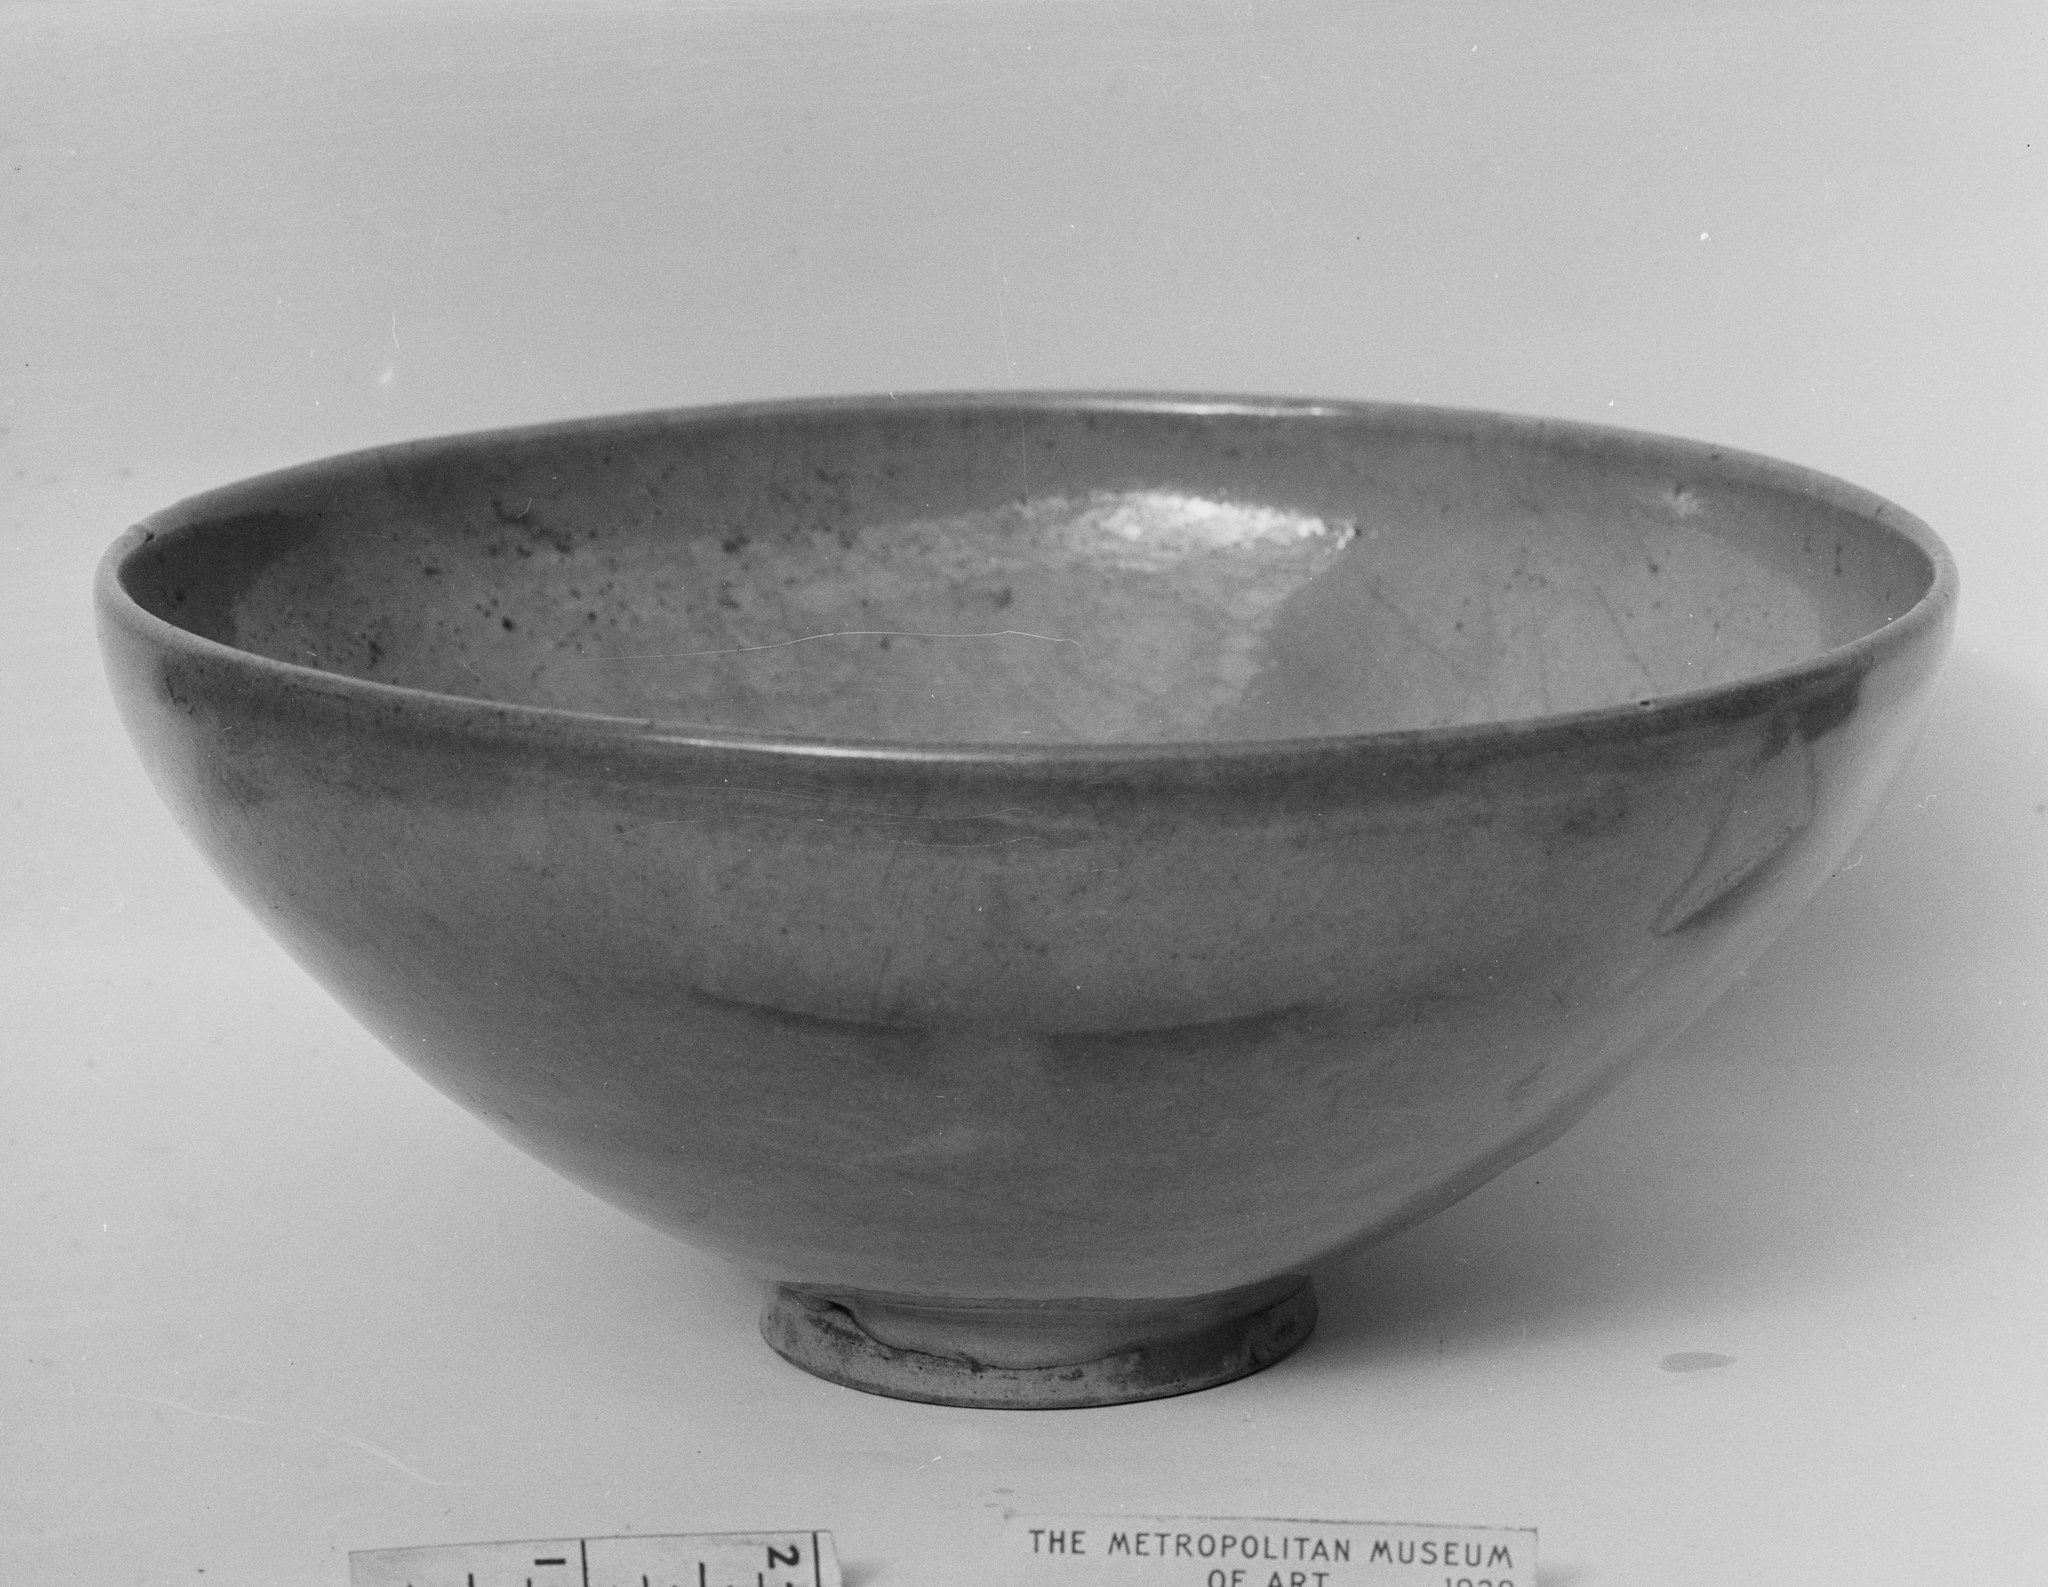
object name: bowl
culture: chinese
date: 960-1279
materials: pottery